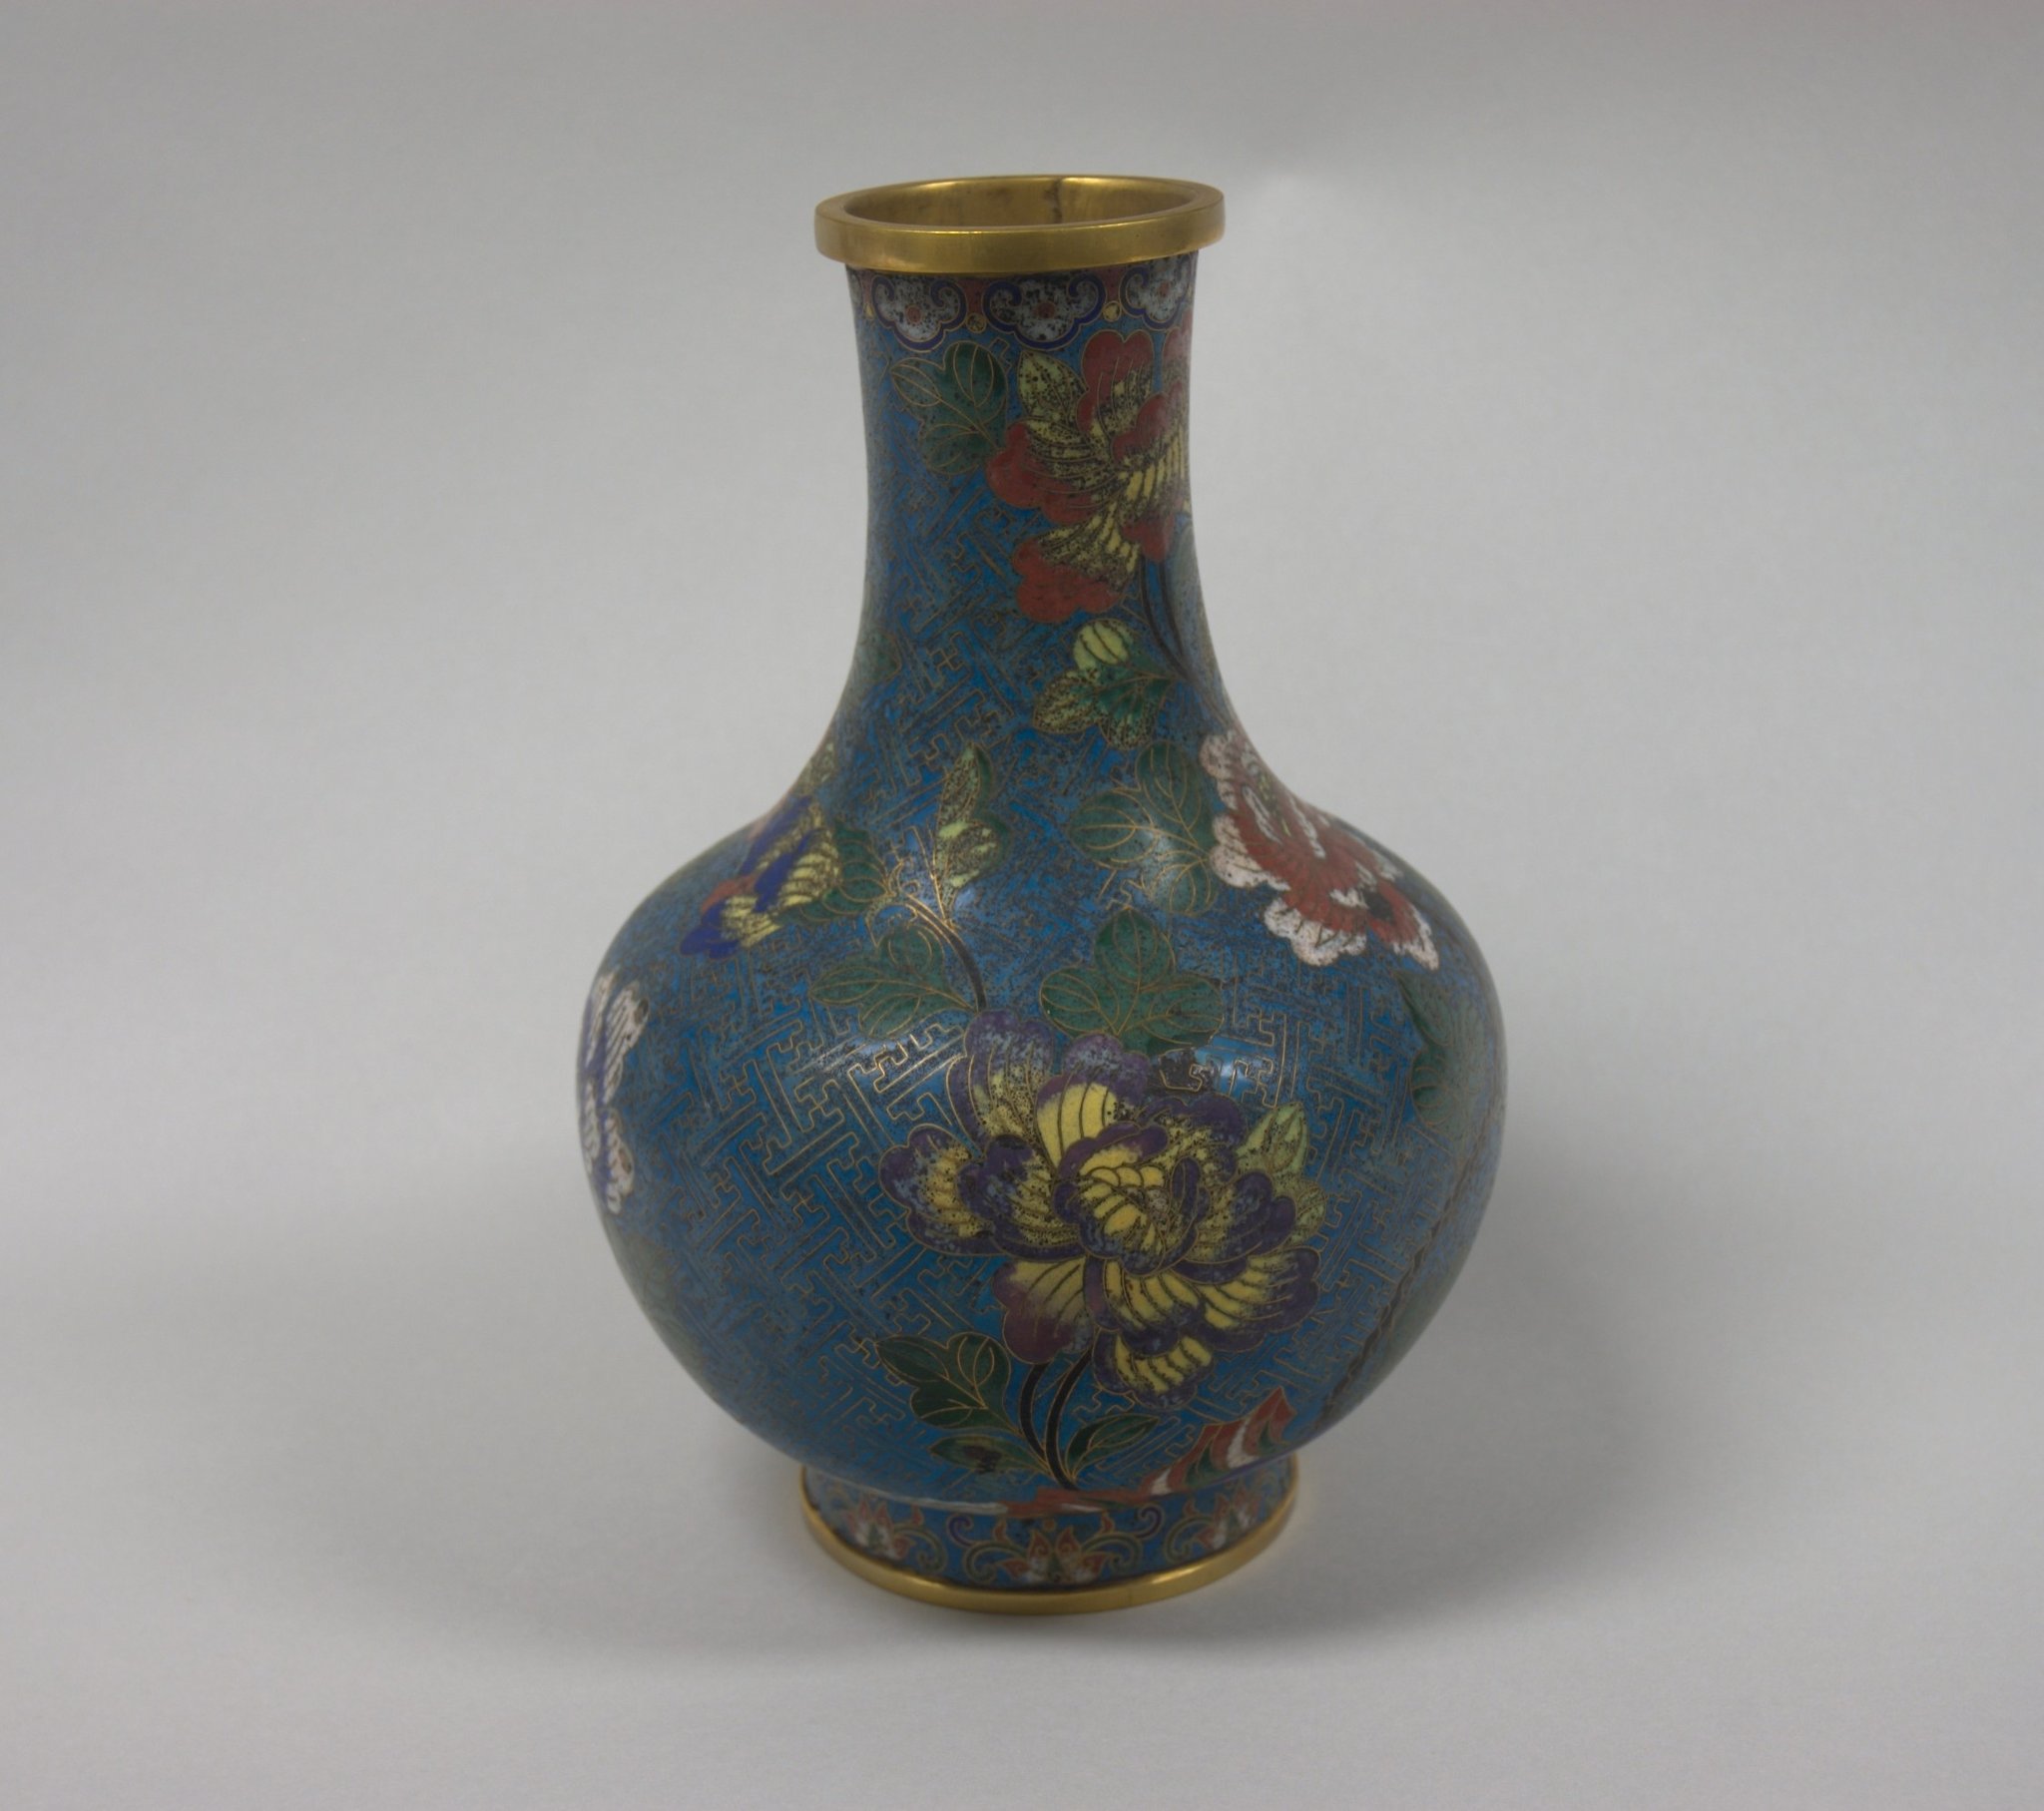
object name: vase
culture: chinese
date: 1662-1722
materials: copper, enamel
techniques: enamel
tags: flowers